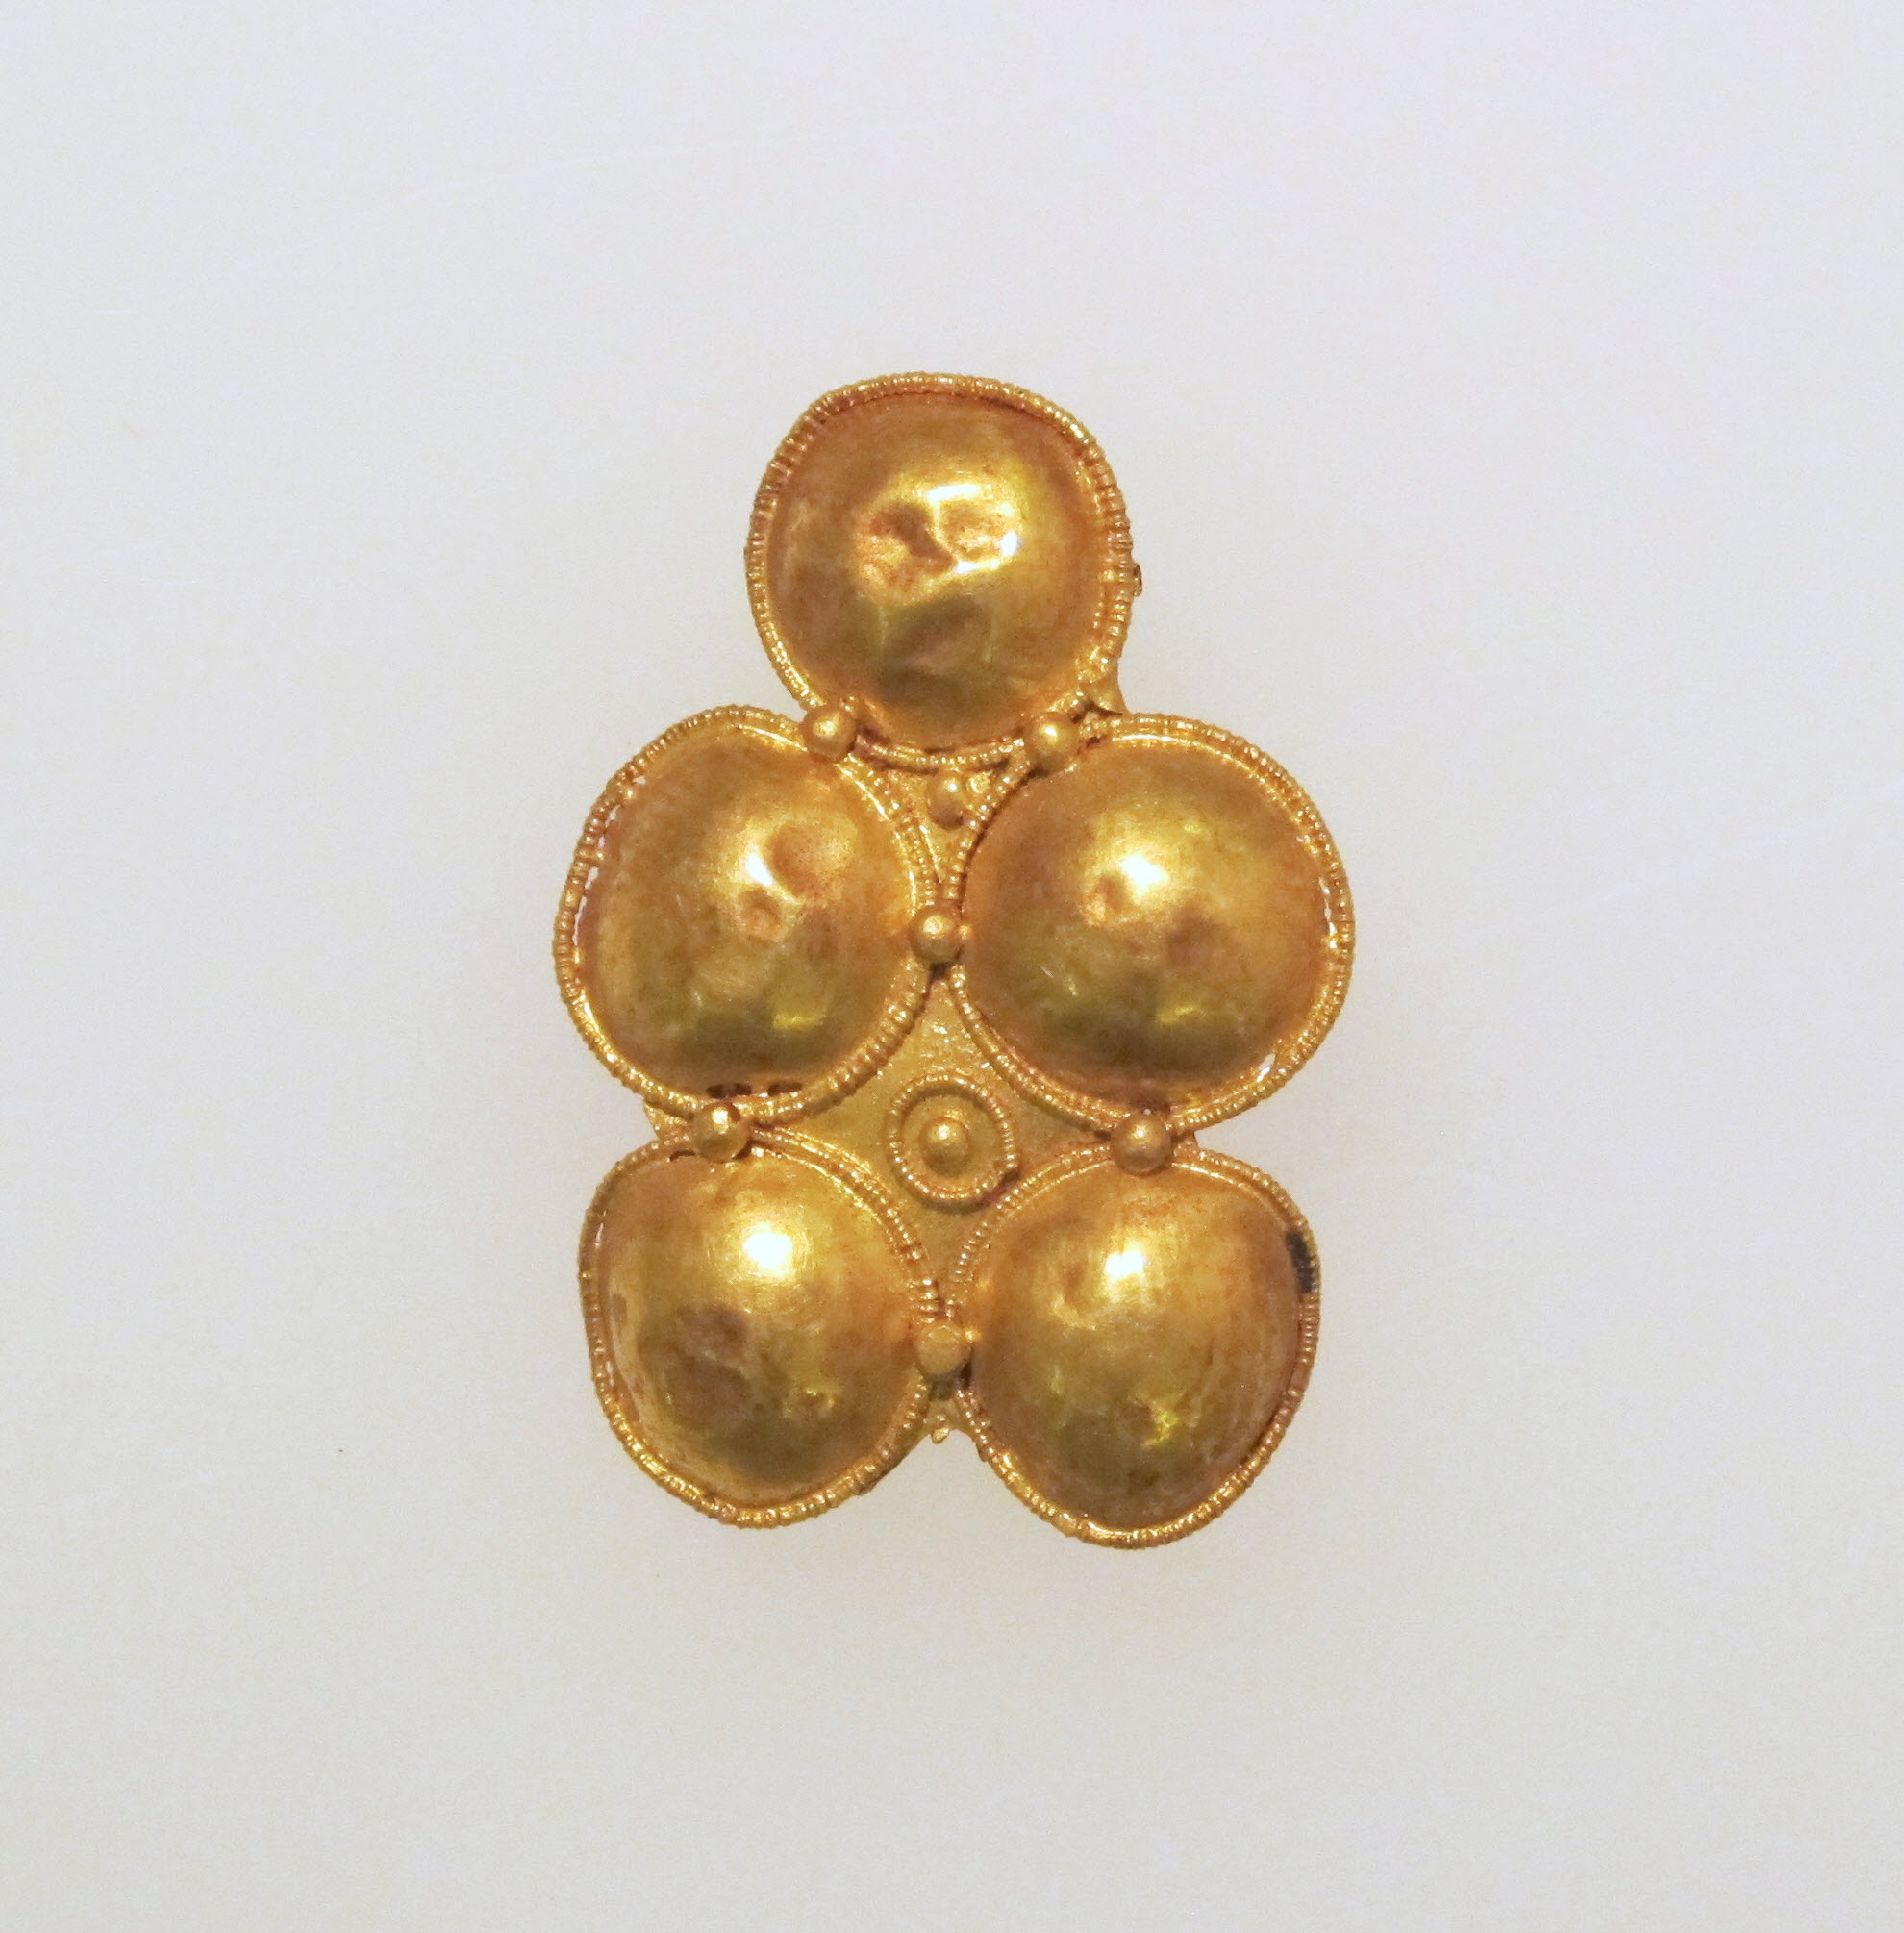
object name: earring hook type with disc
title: Gold hook type earring with discs in filigree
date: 7000 BCE-330 CE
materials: gold